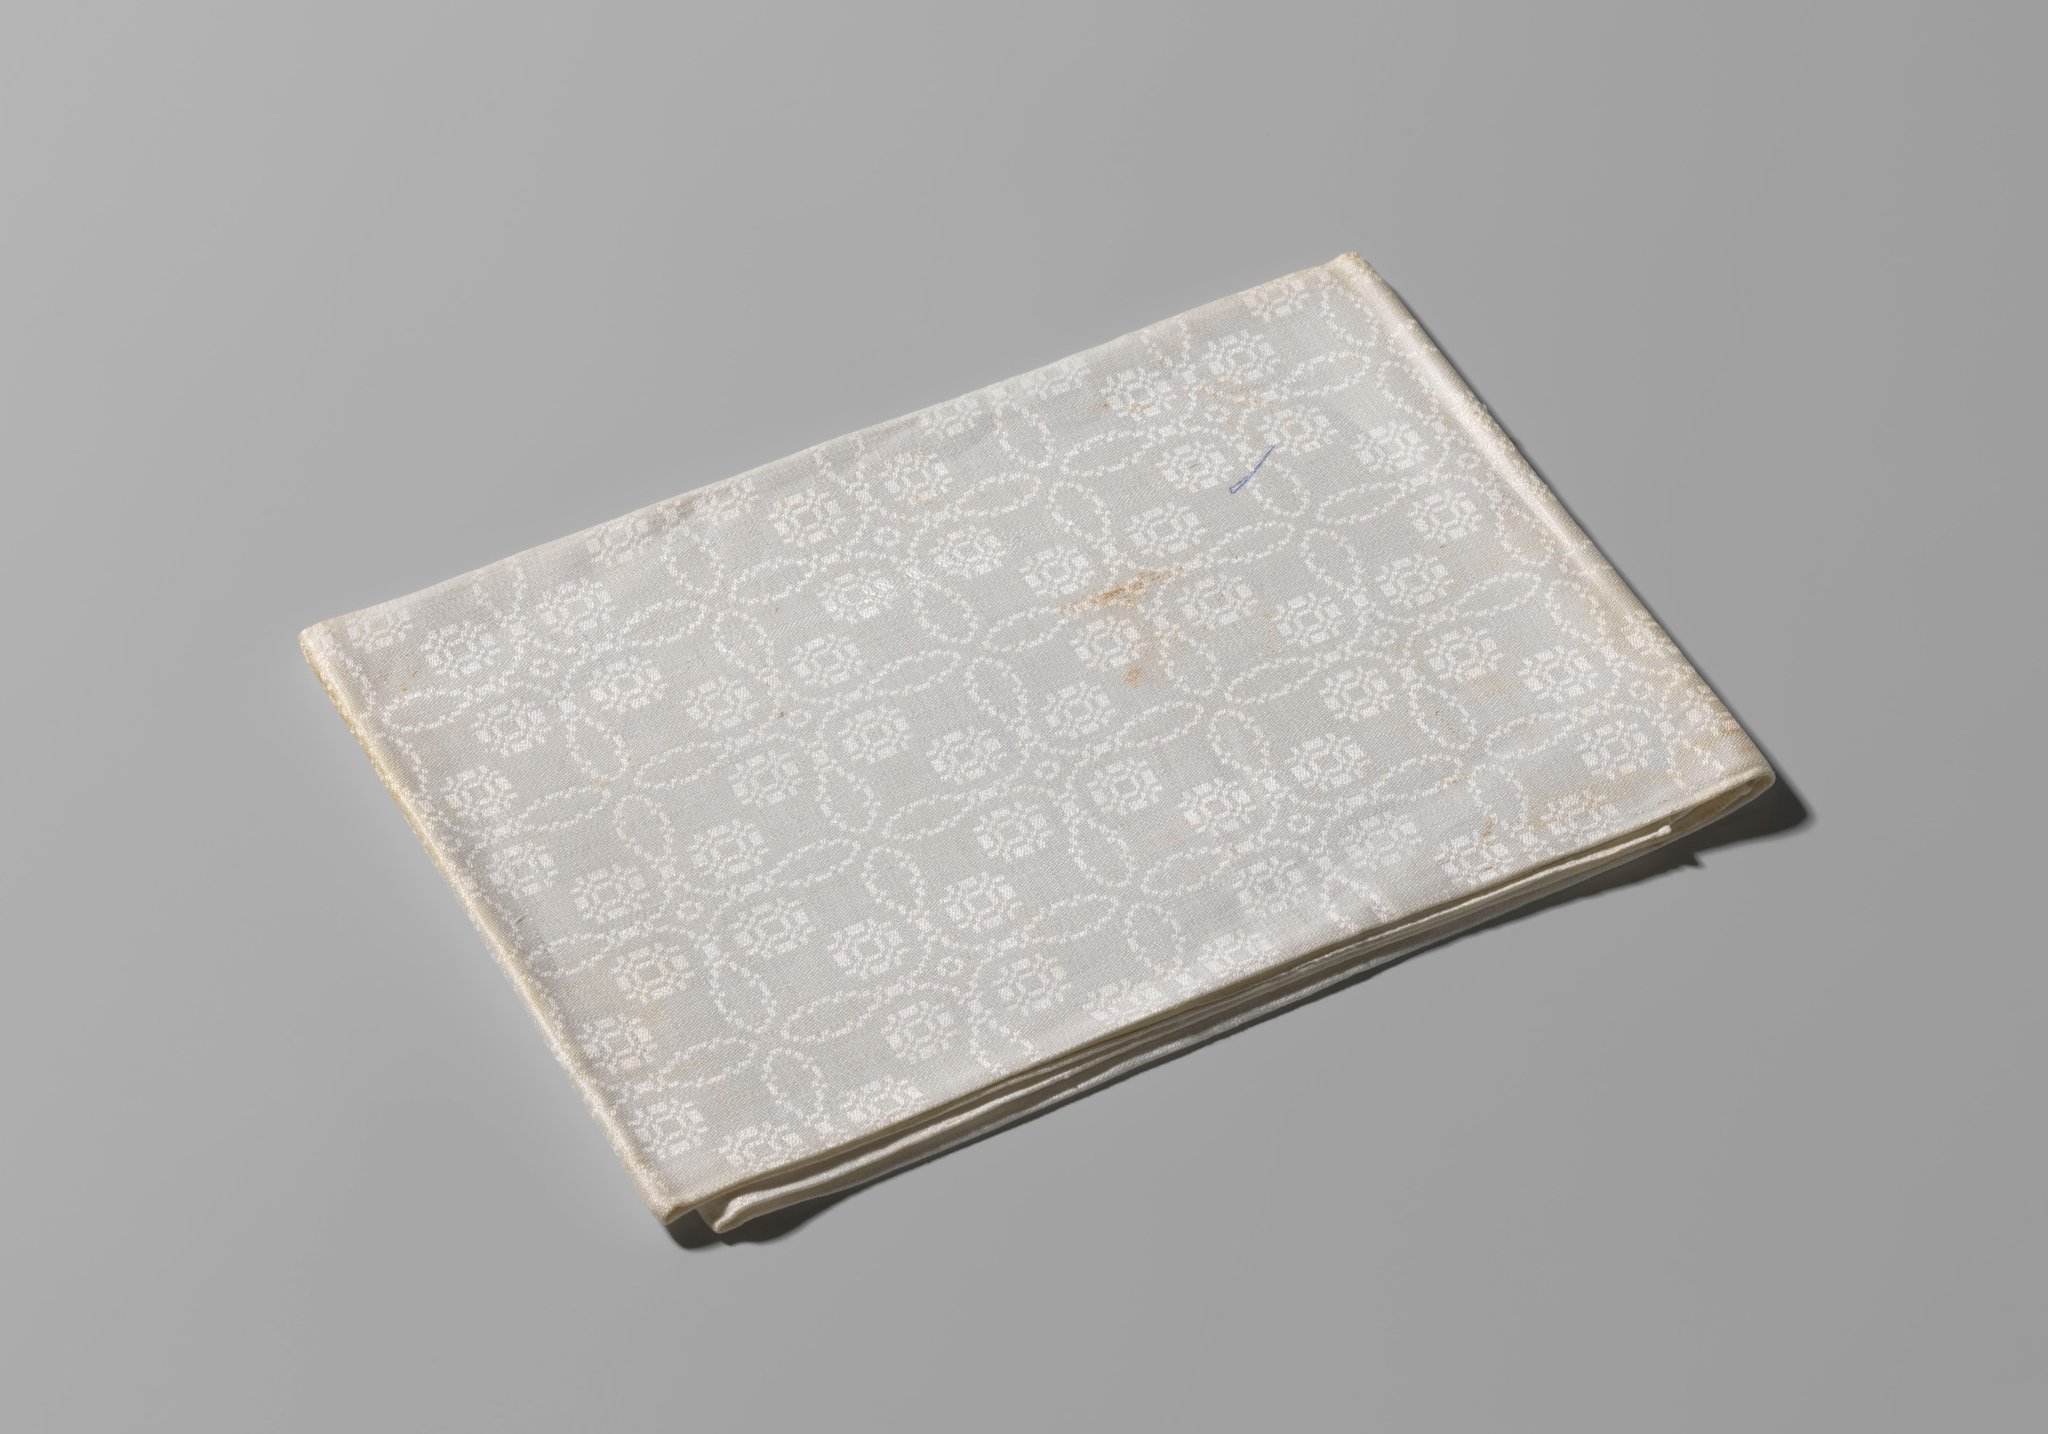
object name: napkin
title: Servet van wit linnen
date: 1690-1710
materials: linen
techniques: peeled fabric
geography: northern netherlands